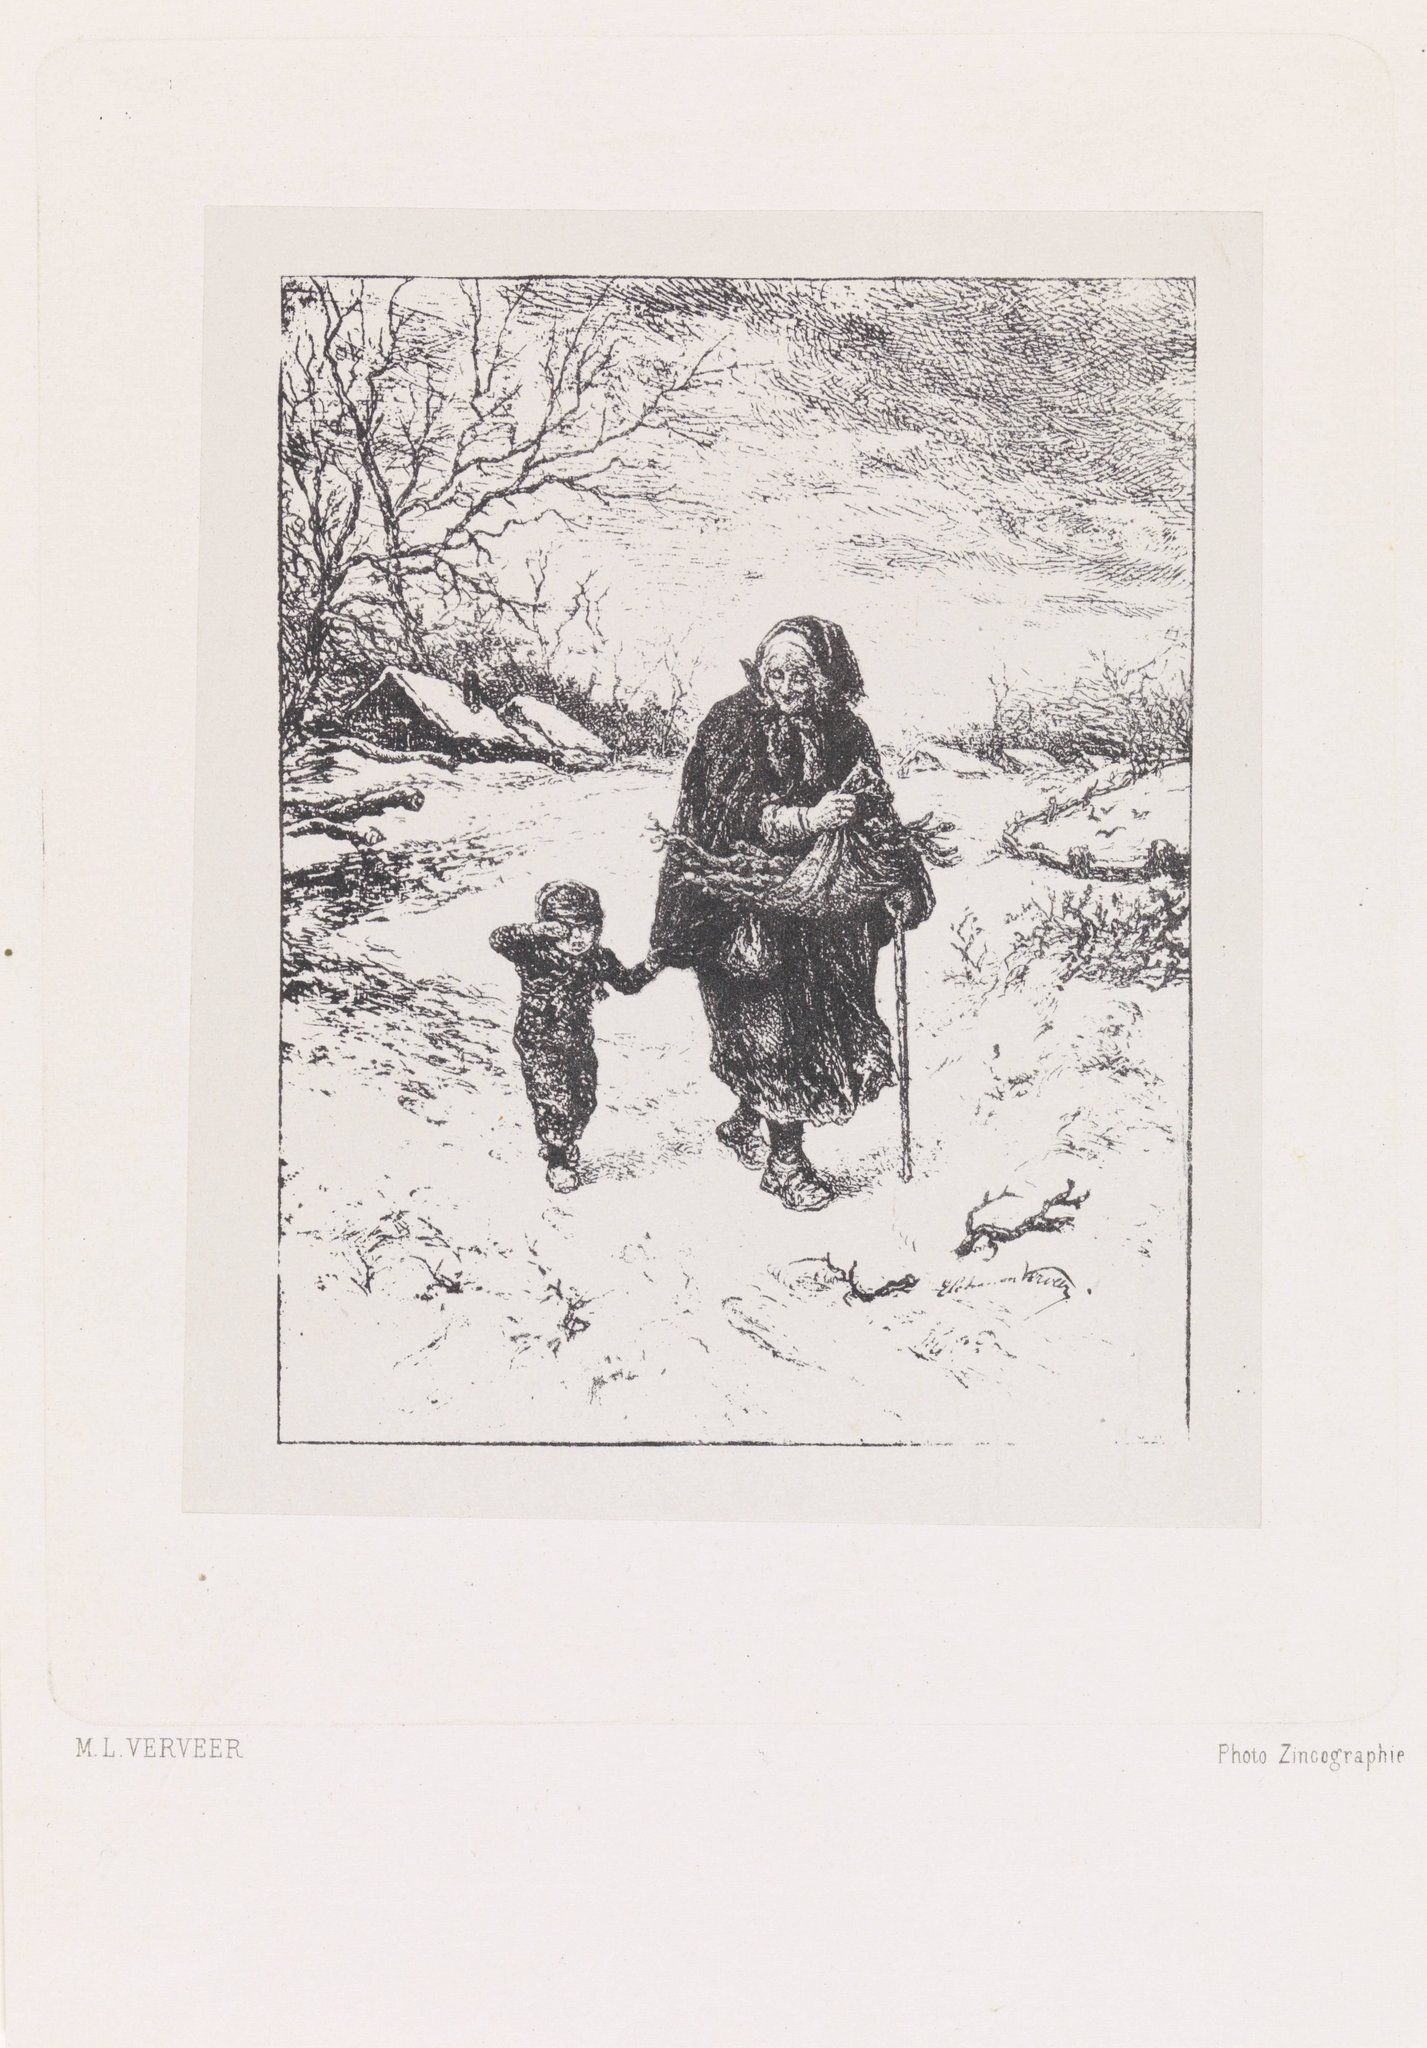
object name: print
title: Houtsprokkelaarsters met een huilend kind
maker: maurits verveer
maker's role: painter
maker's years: 1817-1903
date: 1857-1883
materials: paper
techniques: photo-zincography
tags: woodgathering, woodgatherer, snow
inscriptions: collector's mark: Lugt 2228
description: Een houtsprokkelaarster in een besneeuwd landschap met naast haar een huilend kind.